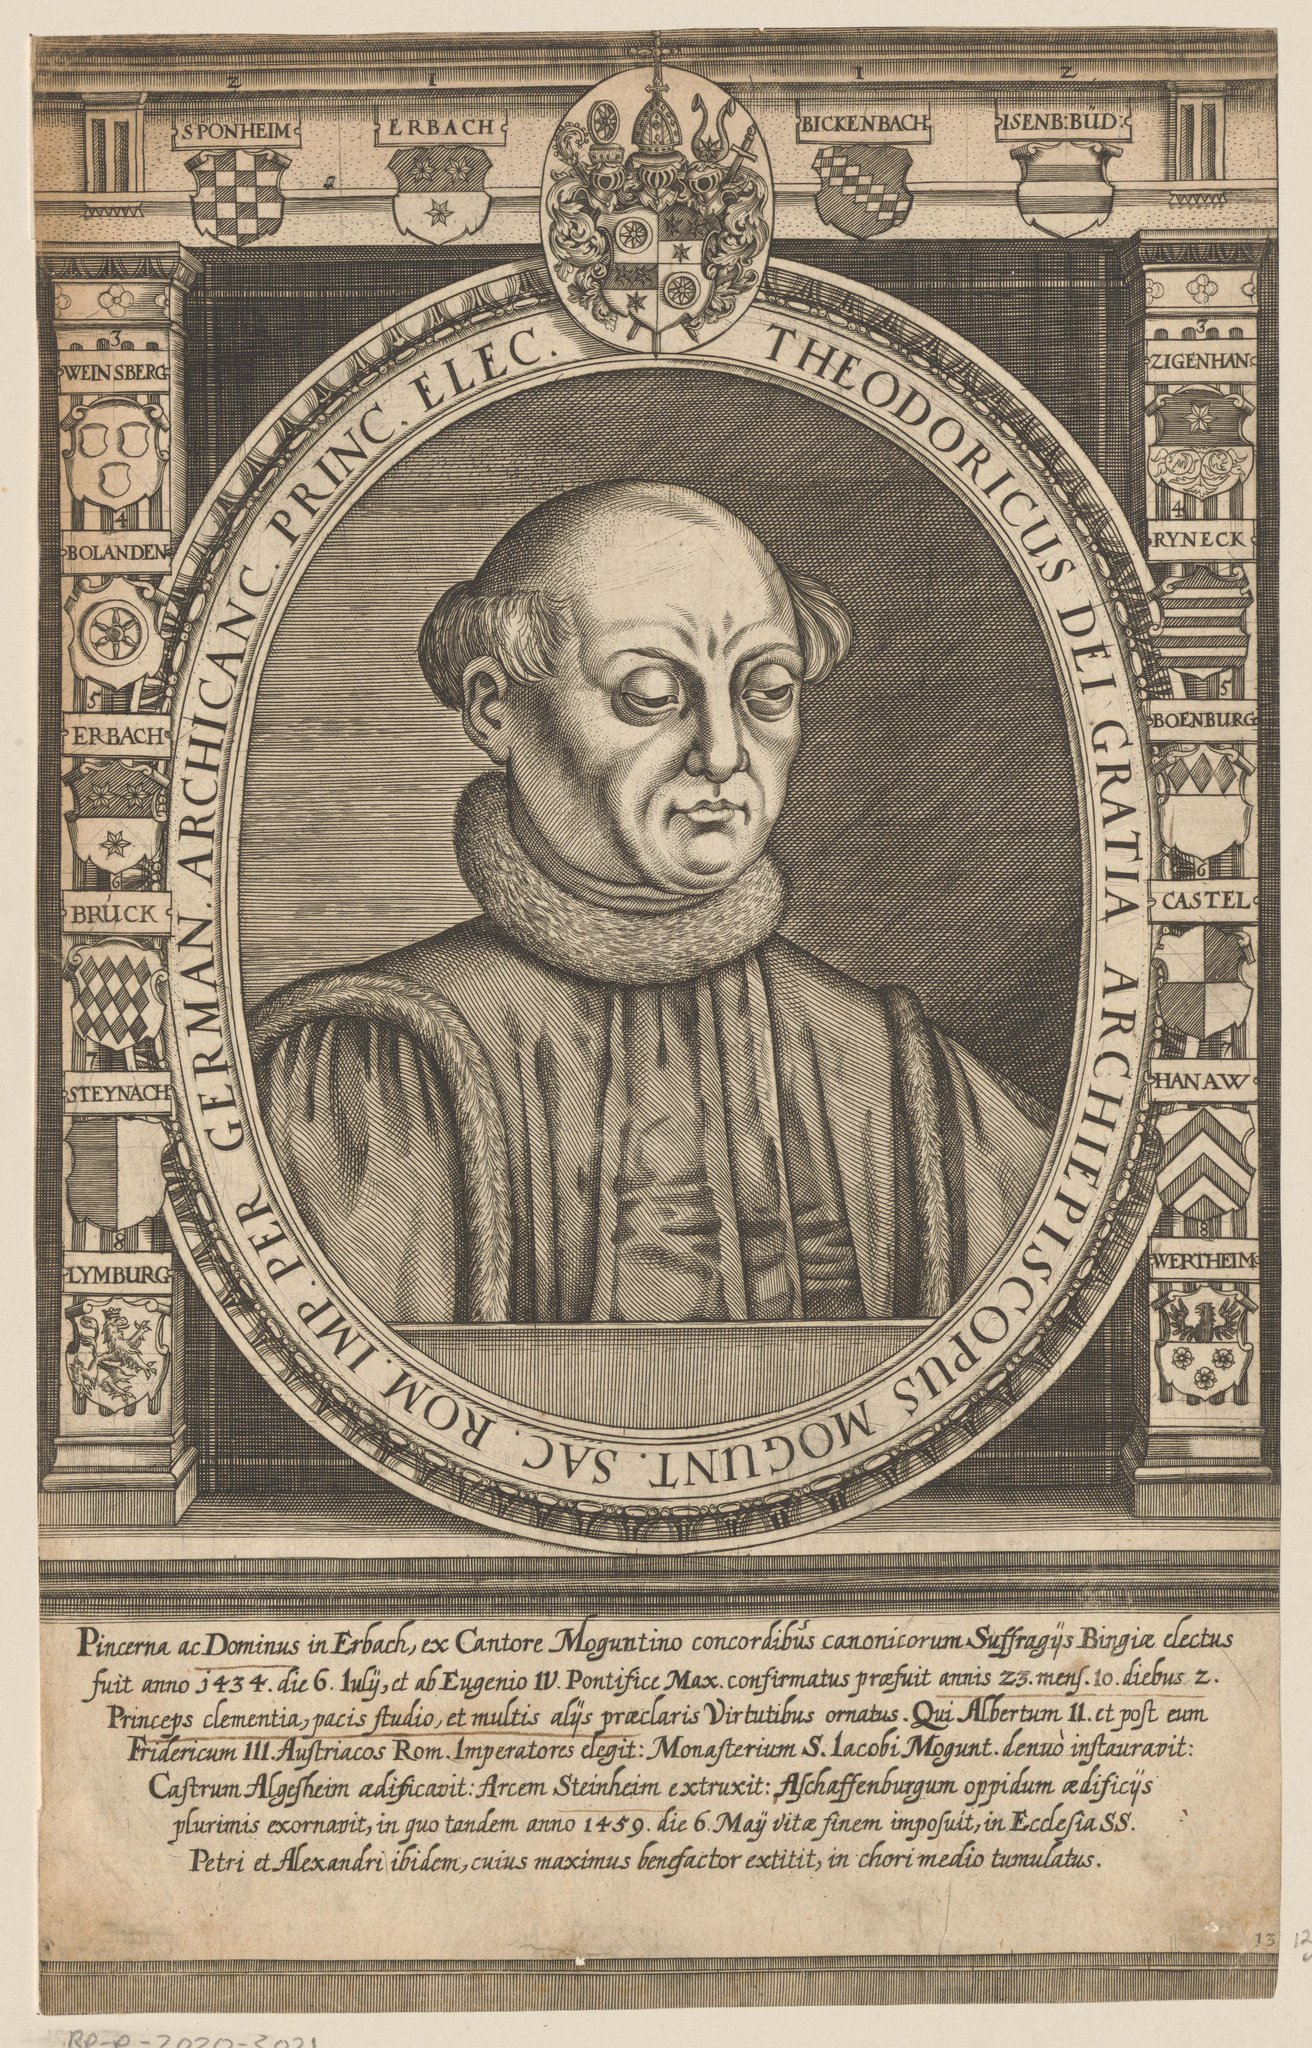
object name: print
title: Portret van Dietrich Schenk von Erbach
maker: sebastian furck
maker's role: print maker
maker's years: 1600-1655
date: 1610-1655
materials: paper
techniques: engraving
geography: germany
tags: archbishop, bishop, etc. (roman catholic), historical persons, armorial bearing, heraldry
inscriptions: collector's mark: ‘P. mariette 1666’, inscription: ‘N. 2373/ 3s’, collector's mark: Lugt 2233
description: Rechtsonder genummerd: 13. Met onderschrift in het Latijn en rondom het portret zestien familiewapens.